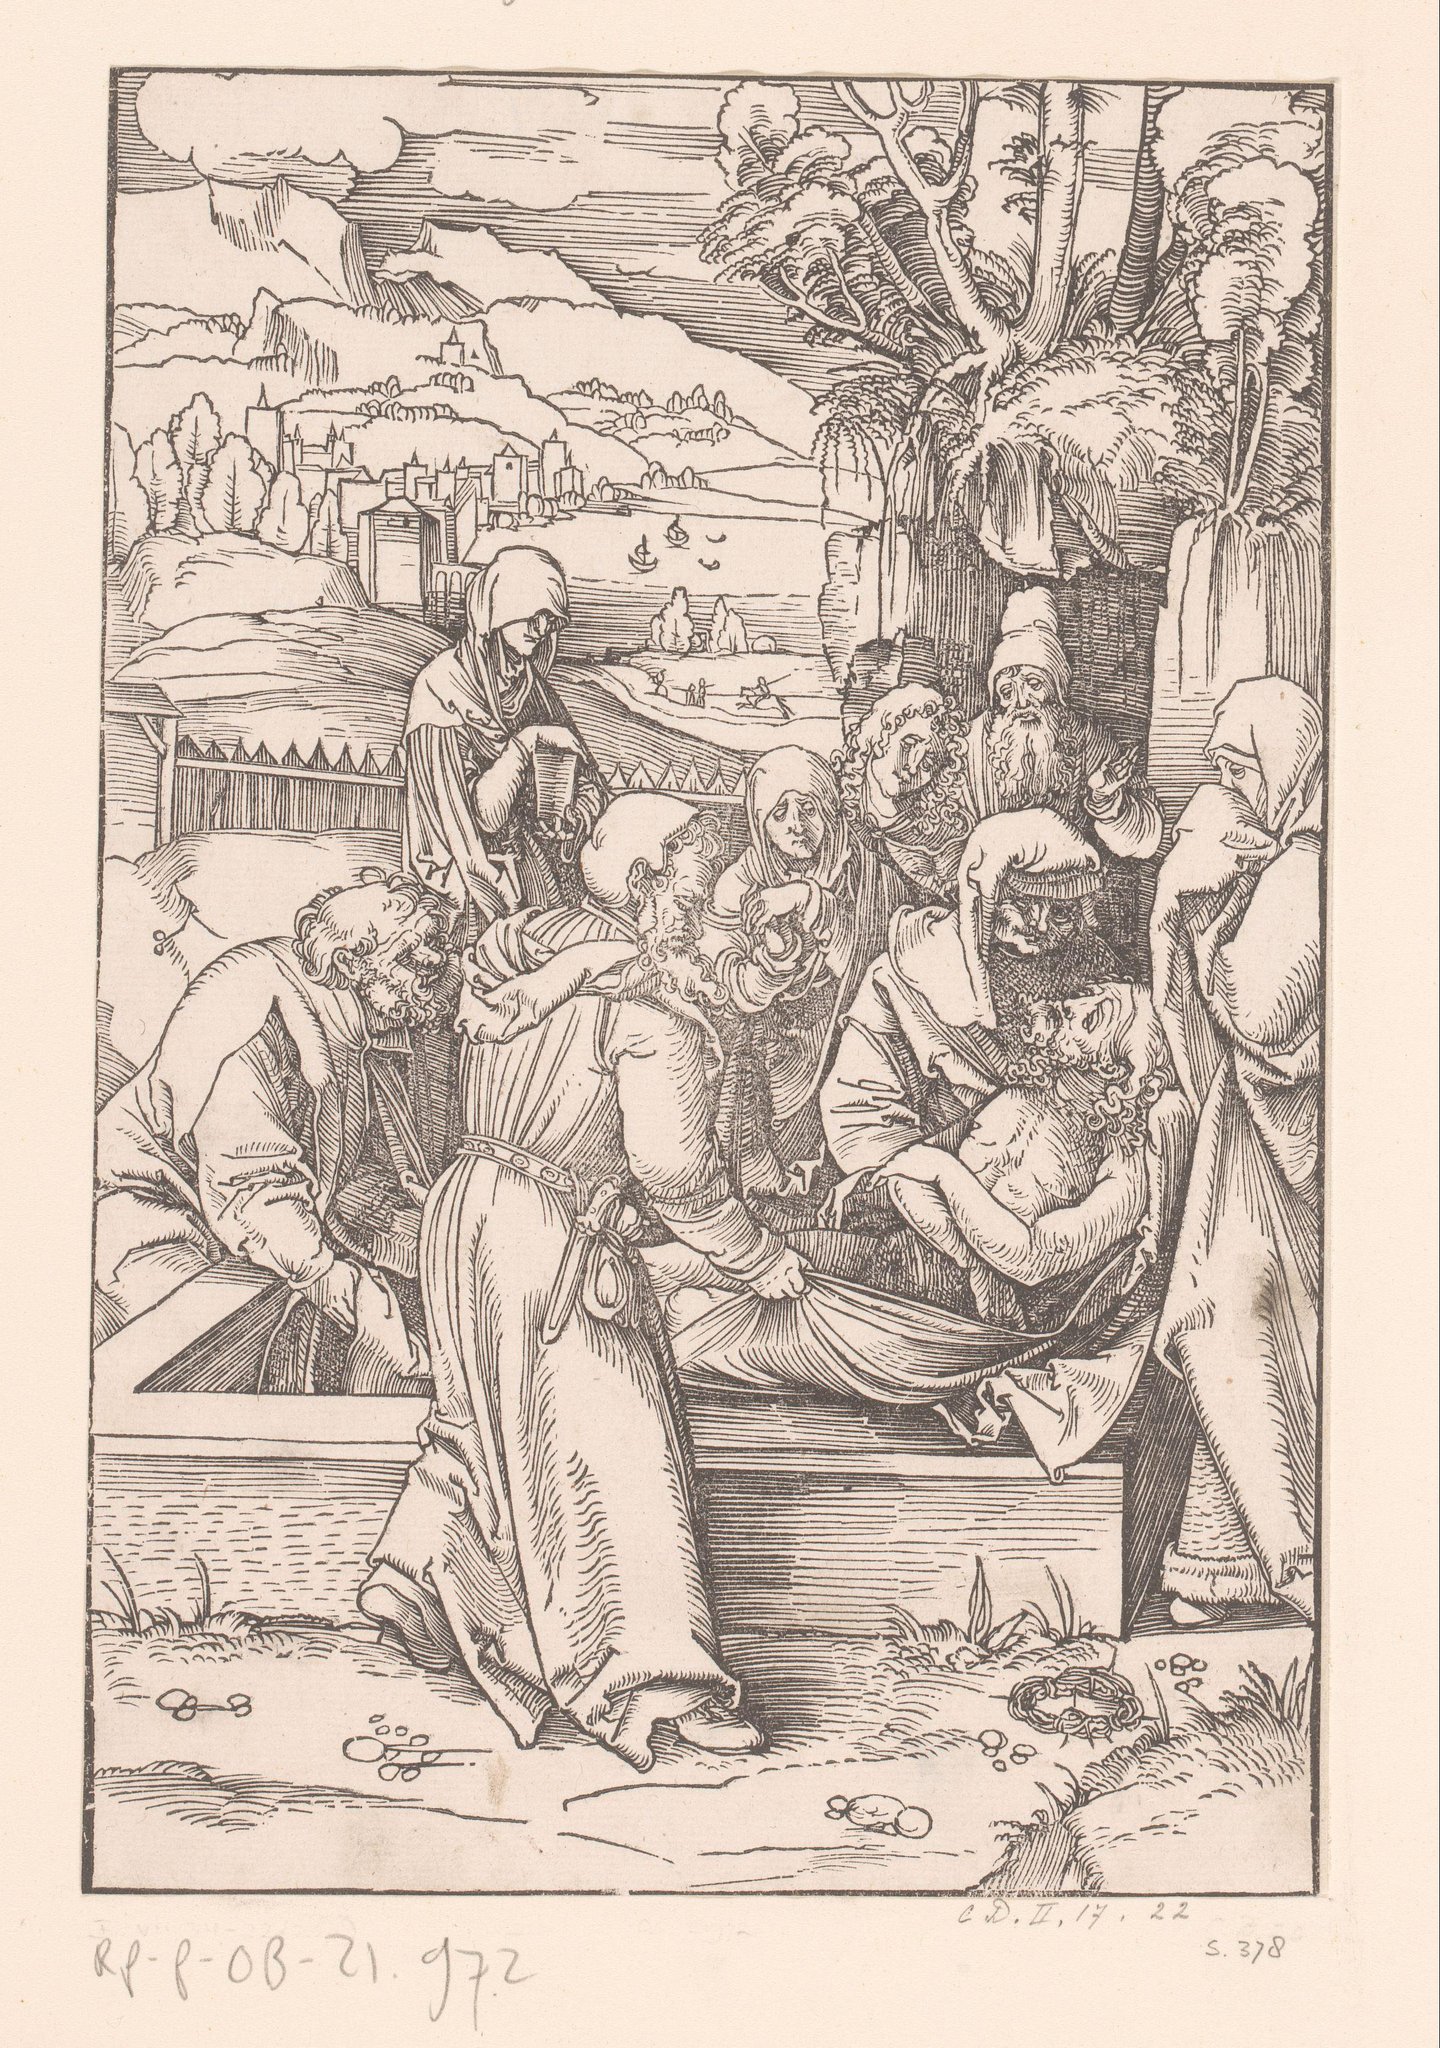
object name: book illustration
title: Graflegging van Christus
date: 1506-1507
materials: paper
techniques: woodcut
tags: christ's entombment (possibly by angels)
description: Prent voor het eerst gebruikt in: Speculum Passionis. Neurenberg: Ulrich Pinder, 1507.